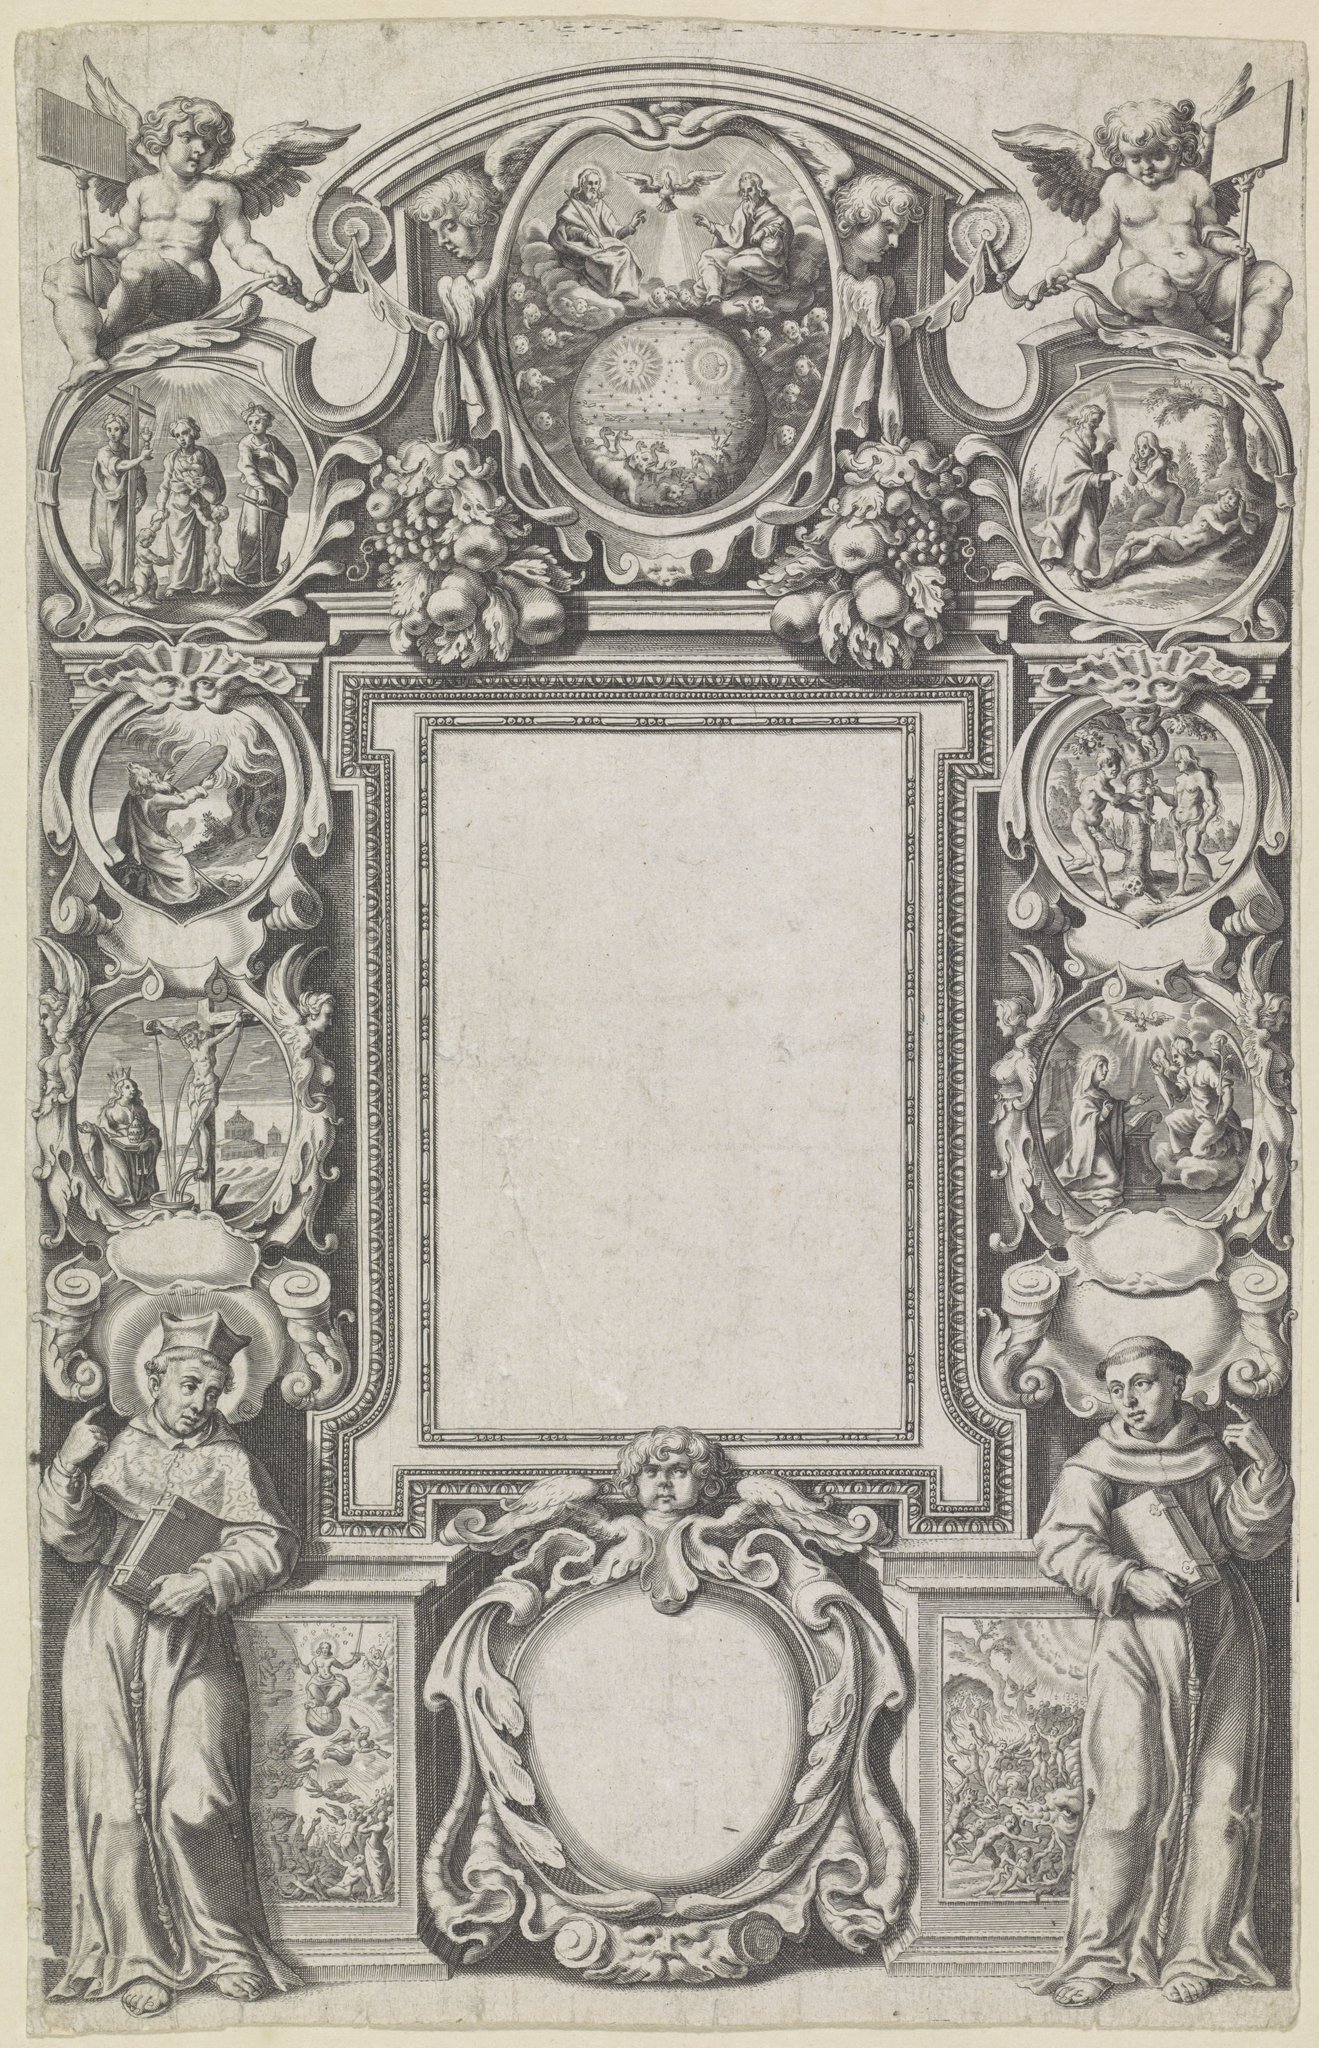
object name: print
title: Titelpagina met twee geestelijken en bijbelse voorstellingen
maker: Anonymous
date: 1650-1750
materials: paper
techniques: engraving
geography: southern netherlands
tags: ornaments ~ art, holy trinity in which one, two or all figures are represented in human shape, organization, functionaries and dignitaries in roman catholic church; clergy in general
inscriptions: collector's mark: Lugt 240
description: Een omlijsting met verschillende cartouches met bijbelse voorstellingen. Linksonder een rooms-katholieke geestelijkem, rechtsonder een monnik. Midden boven een cartouche met de Heilige Drie-eenheid en een verbeelding van de schepping. Met de klok mee: De schepping van Eva, de zondeval, de annunciatie aan Maria, de kruisiging, Mozes met de Tafelen der Wet en een cartouche met Geloof, Hoop en Liefde. Op de basementen onderaan het laatste oordeel en de hel. Midden onder een leeg ornamenteel cartouche. Mogelijk een titelpagina.